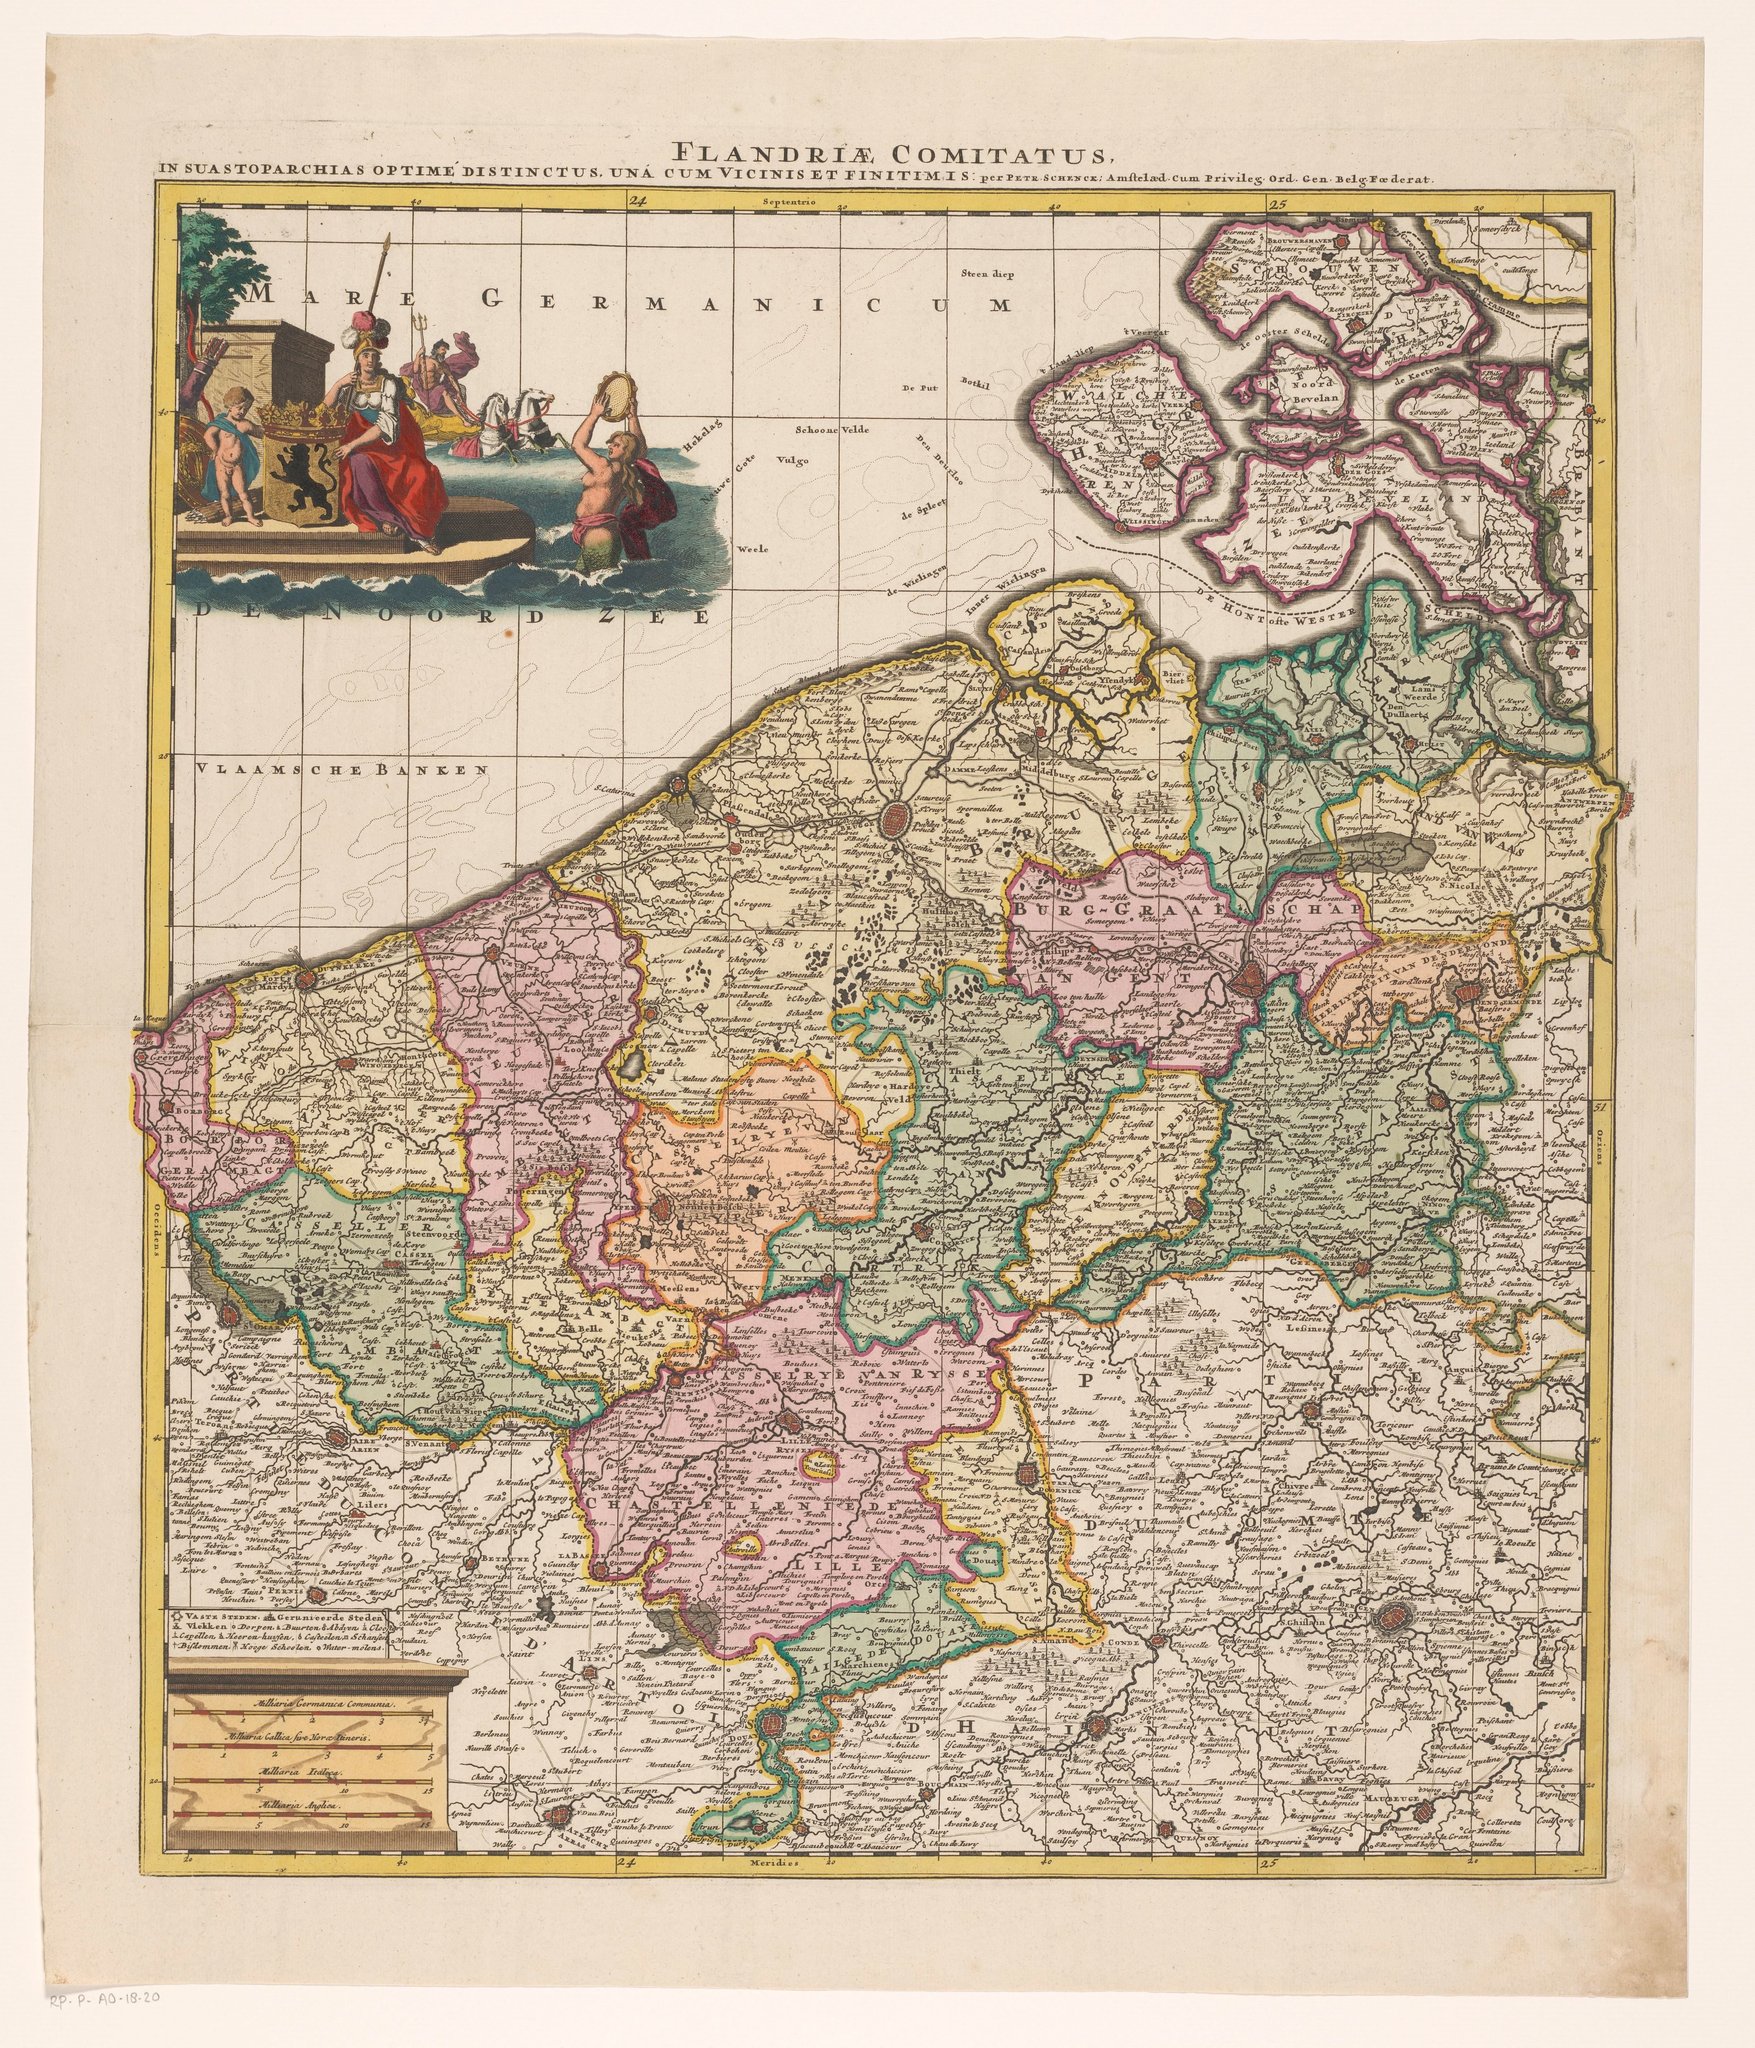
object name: map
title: Kaart van het graafschap Vlaanderen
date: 1695-1711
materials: paper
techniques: engraving, etching, hand coloring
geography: amsterdam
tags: (story of) neptune (poseidon), maps of separate countries or regions, (story of) minerva (pallas, athena), coat of arms (as symbol of the state, etc.) (+ province; provincial), zeeland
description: Kaart van het graafschap Vlaanderen. De titel boven de kaart. Linksonder een cartouche met vier schaalstokken: 3 3/4 Milliaria Germanica Communia / 5 Milliaria Gallica Sive Horae Itineris, en twee andere. Boven de cartouche een kader met legenda. Linksboven een voorstelling met Minerva en Neptunes bij het wapen van het graafschap Vlaanderen. De kaart is voorzien van een coördinaten-net en een gradenverdeling langs de randen.